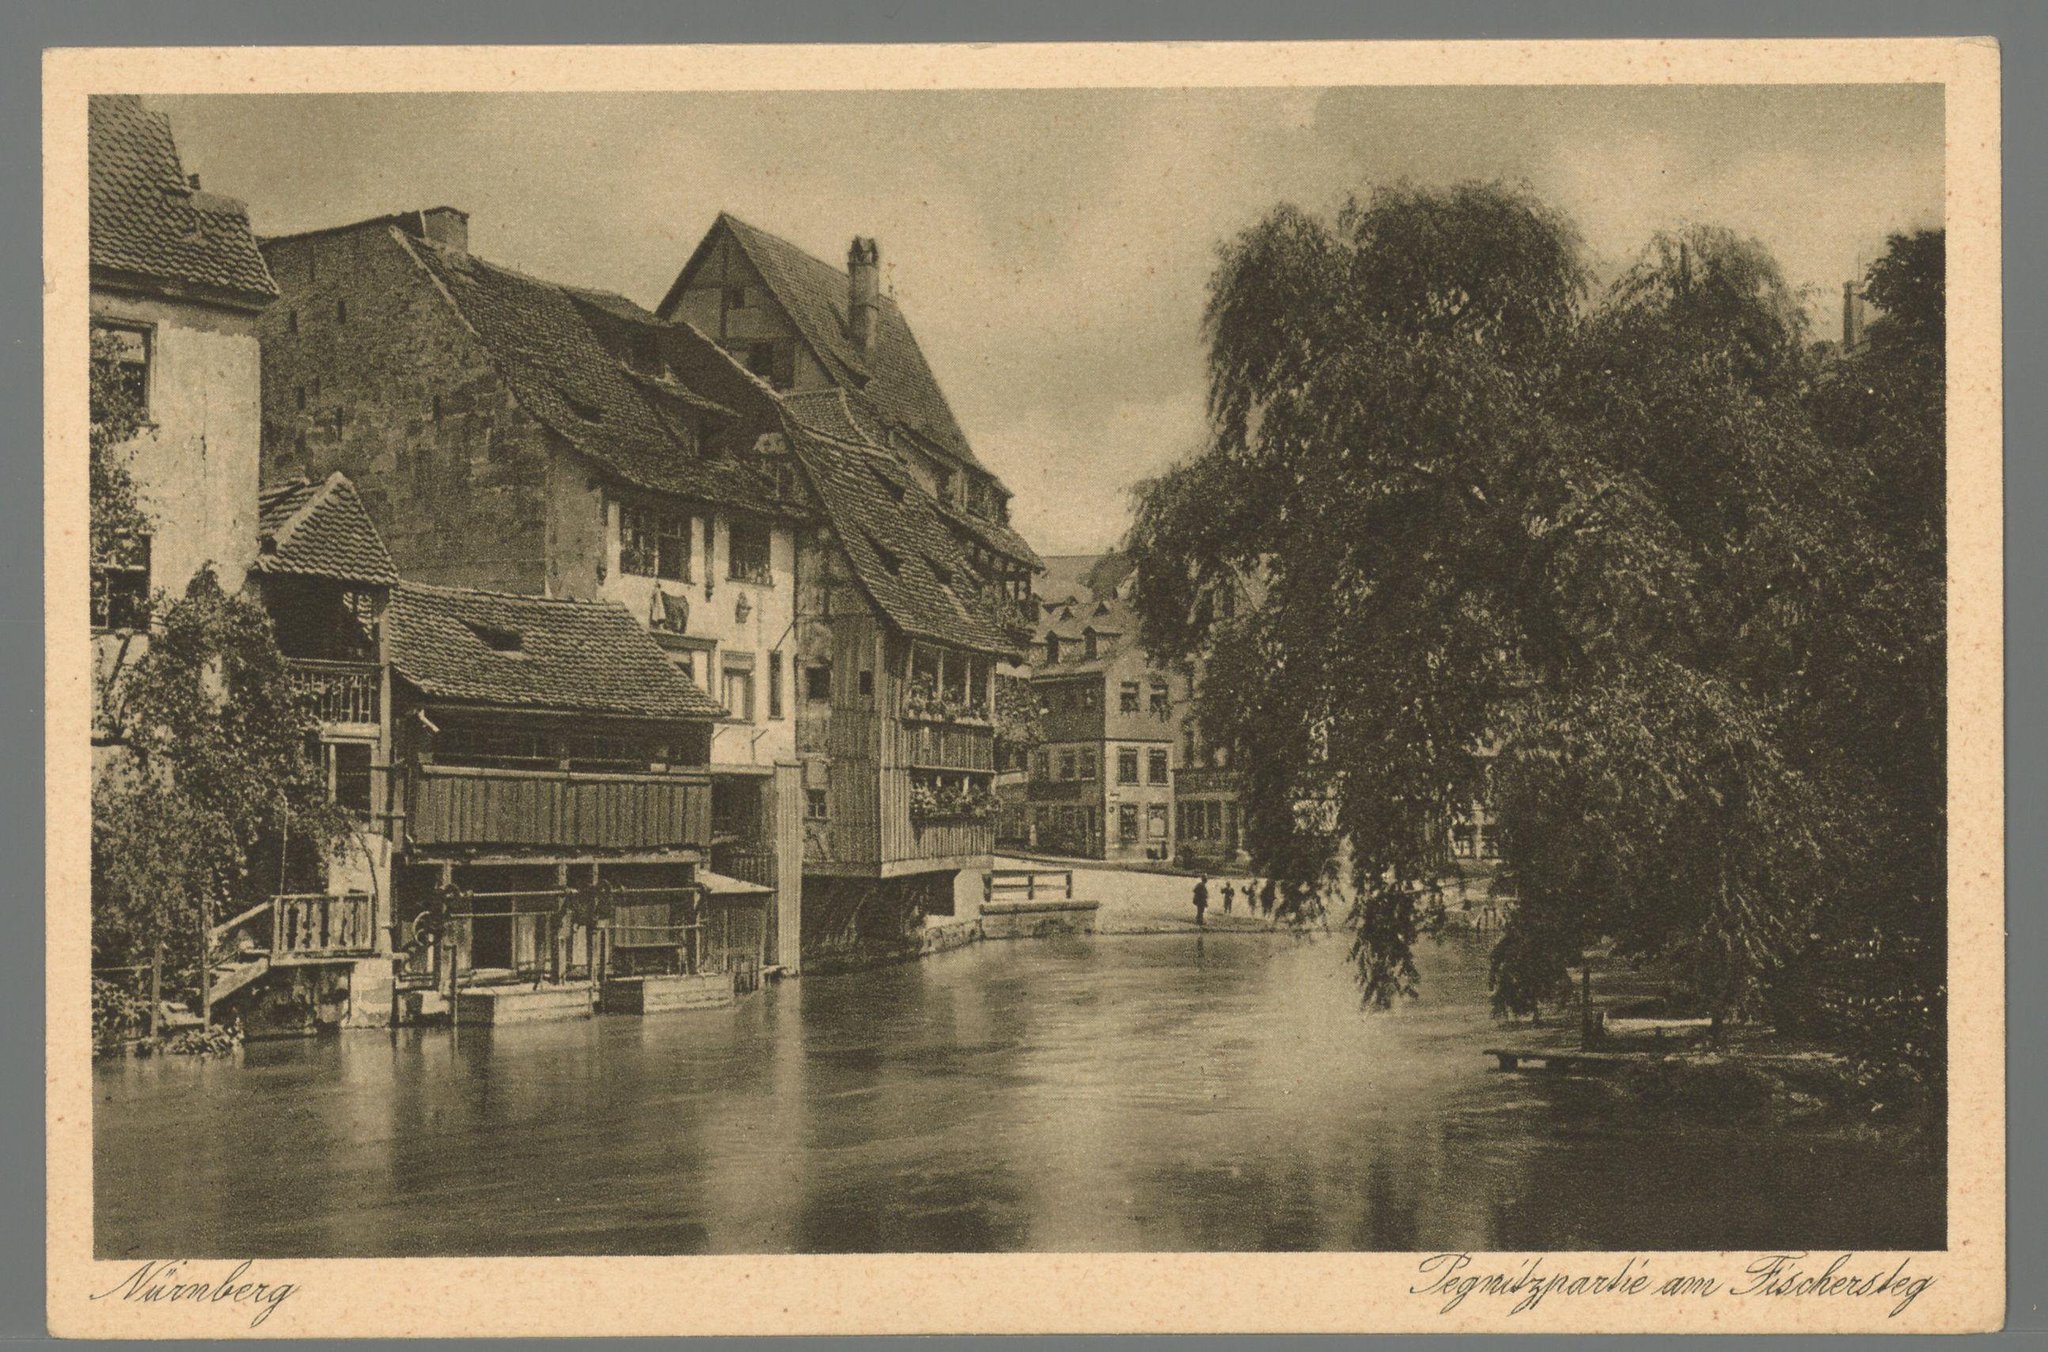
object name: photomechanical print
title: Nürnberg. Pegnitzpartie am Fischersteg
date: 1905-1930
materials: cardboard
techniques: rotogravure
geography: nuremberg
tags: housing, canals, waters (in city)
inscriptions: inscription: ‘Riha Karte’